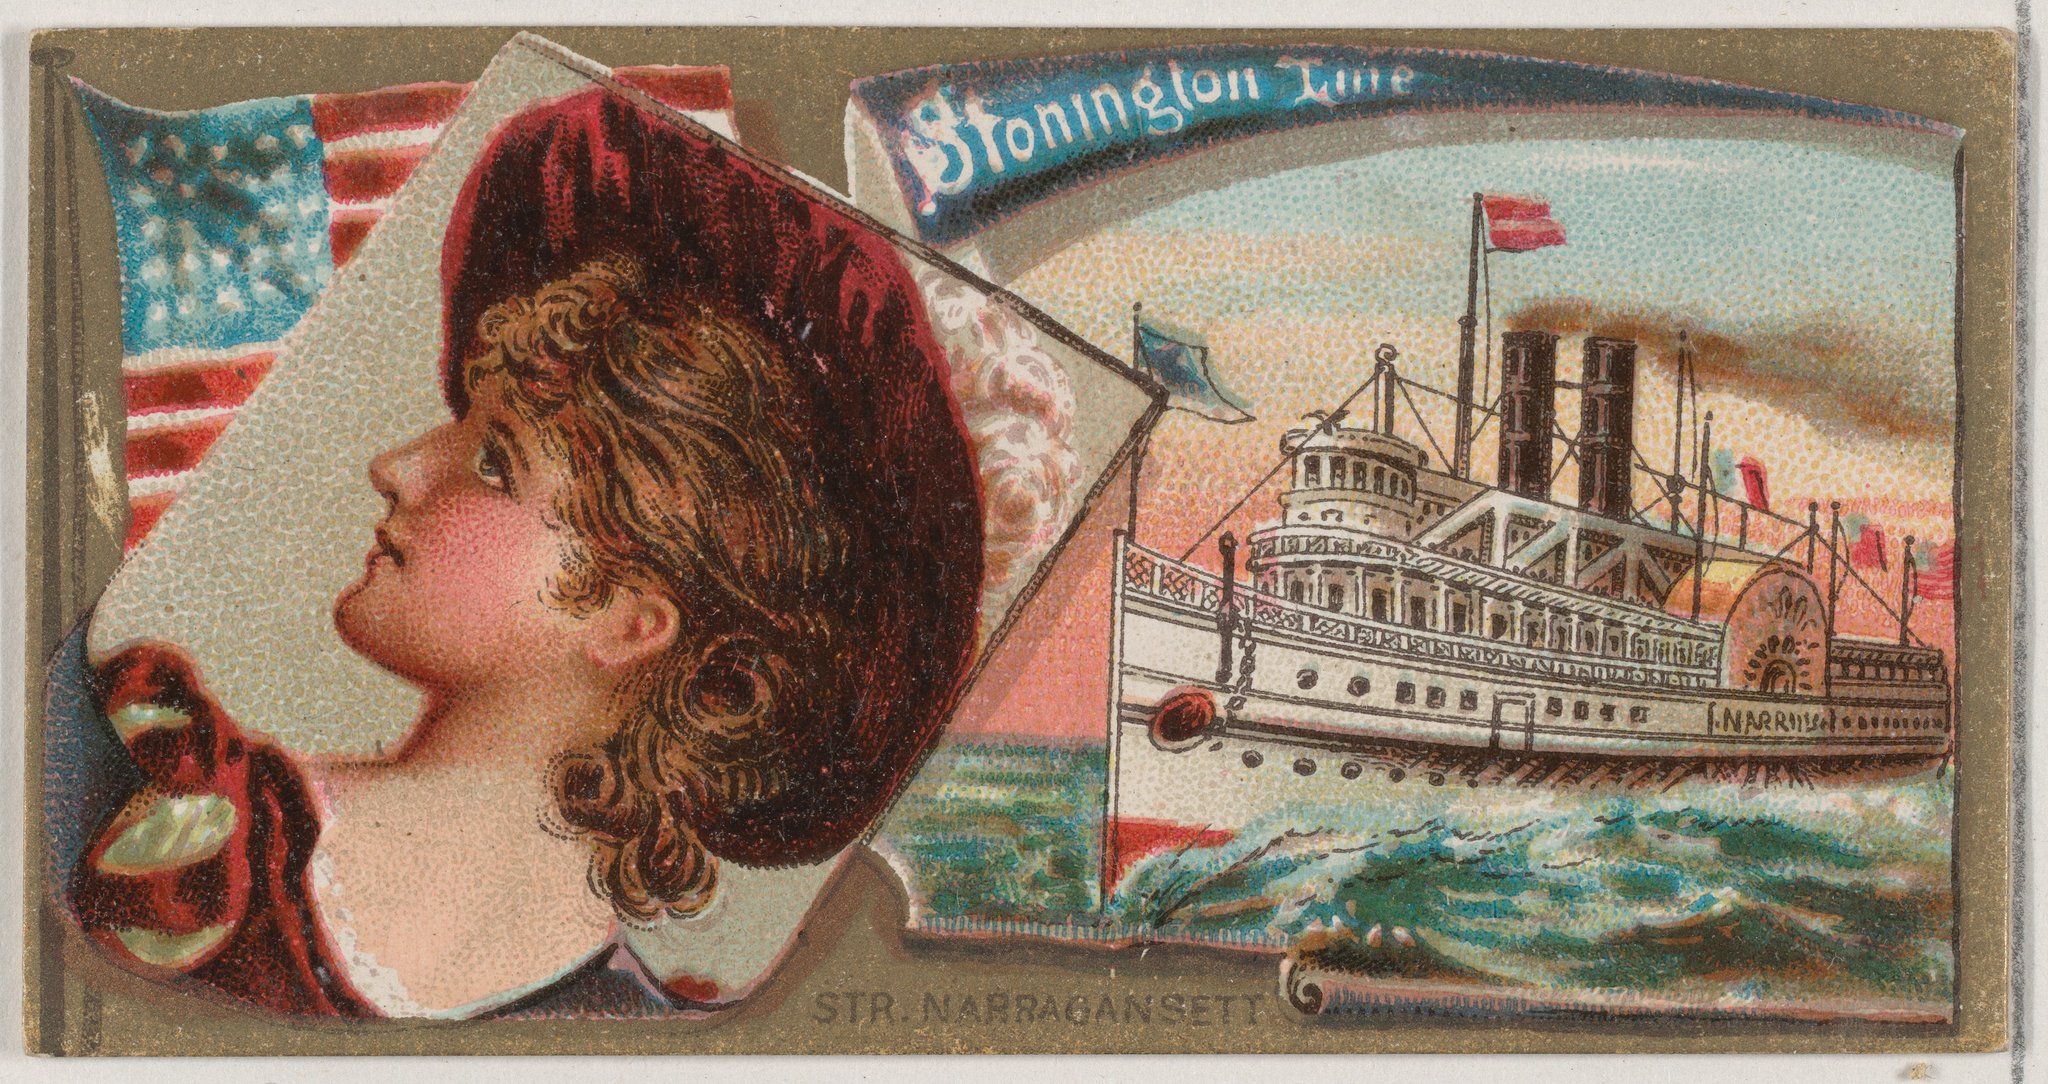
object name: print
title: Steamship Narragansett, Stonington Line, from the Ocean and River Steamers series (N83) for Duke brand cigarettes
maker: w. duke, sons & co.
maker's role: publisher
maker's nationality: american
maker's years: 1870-1920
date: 1887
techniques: color lithograph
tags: women,ships